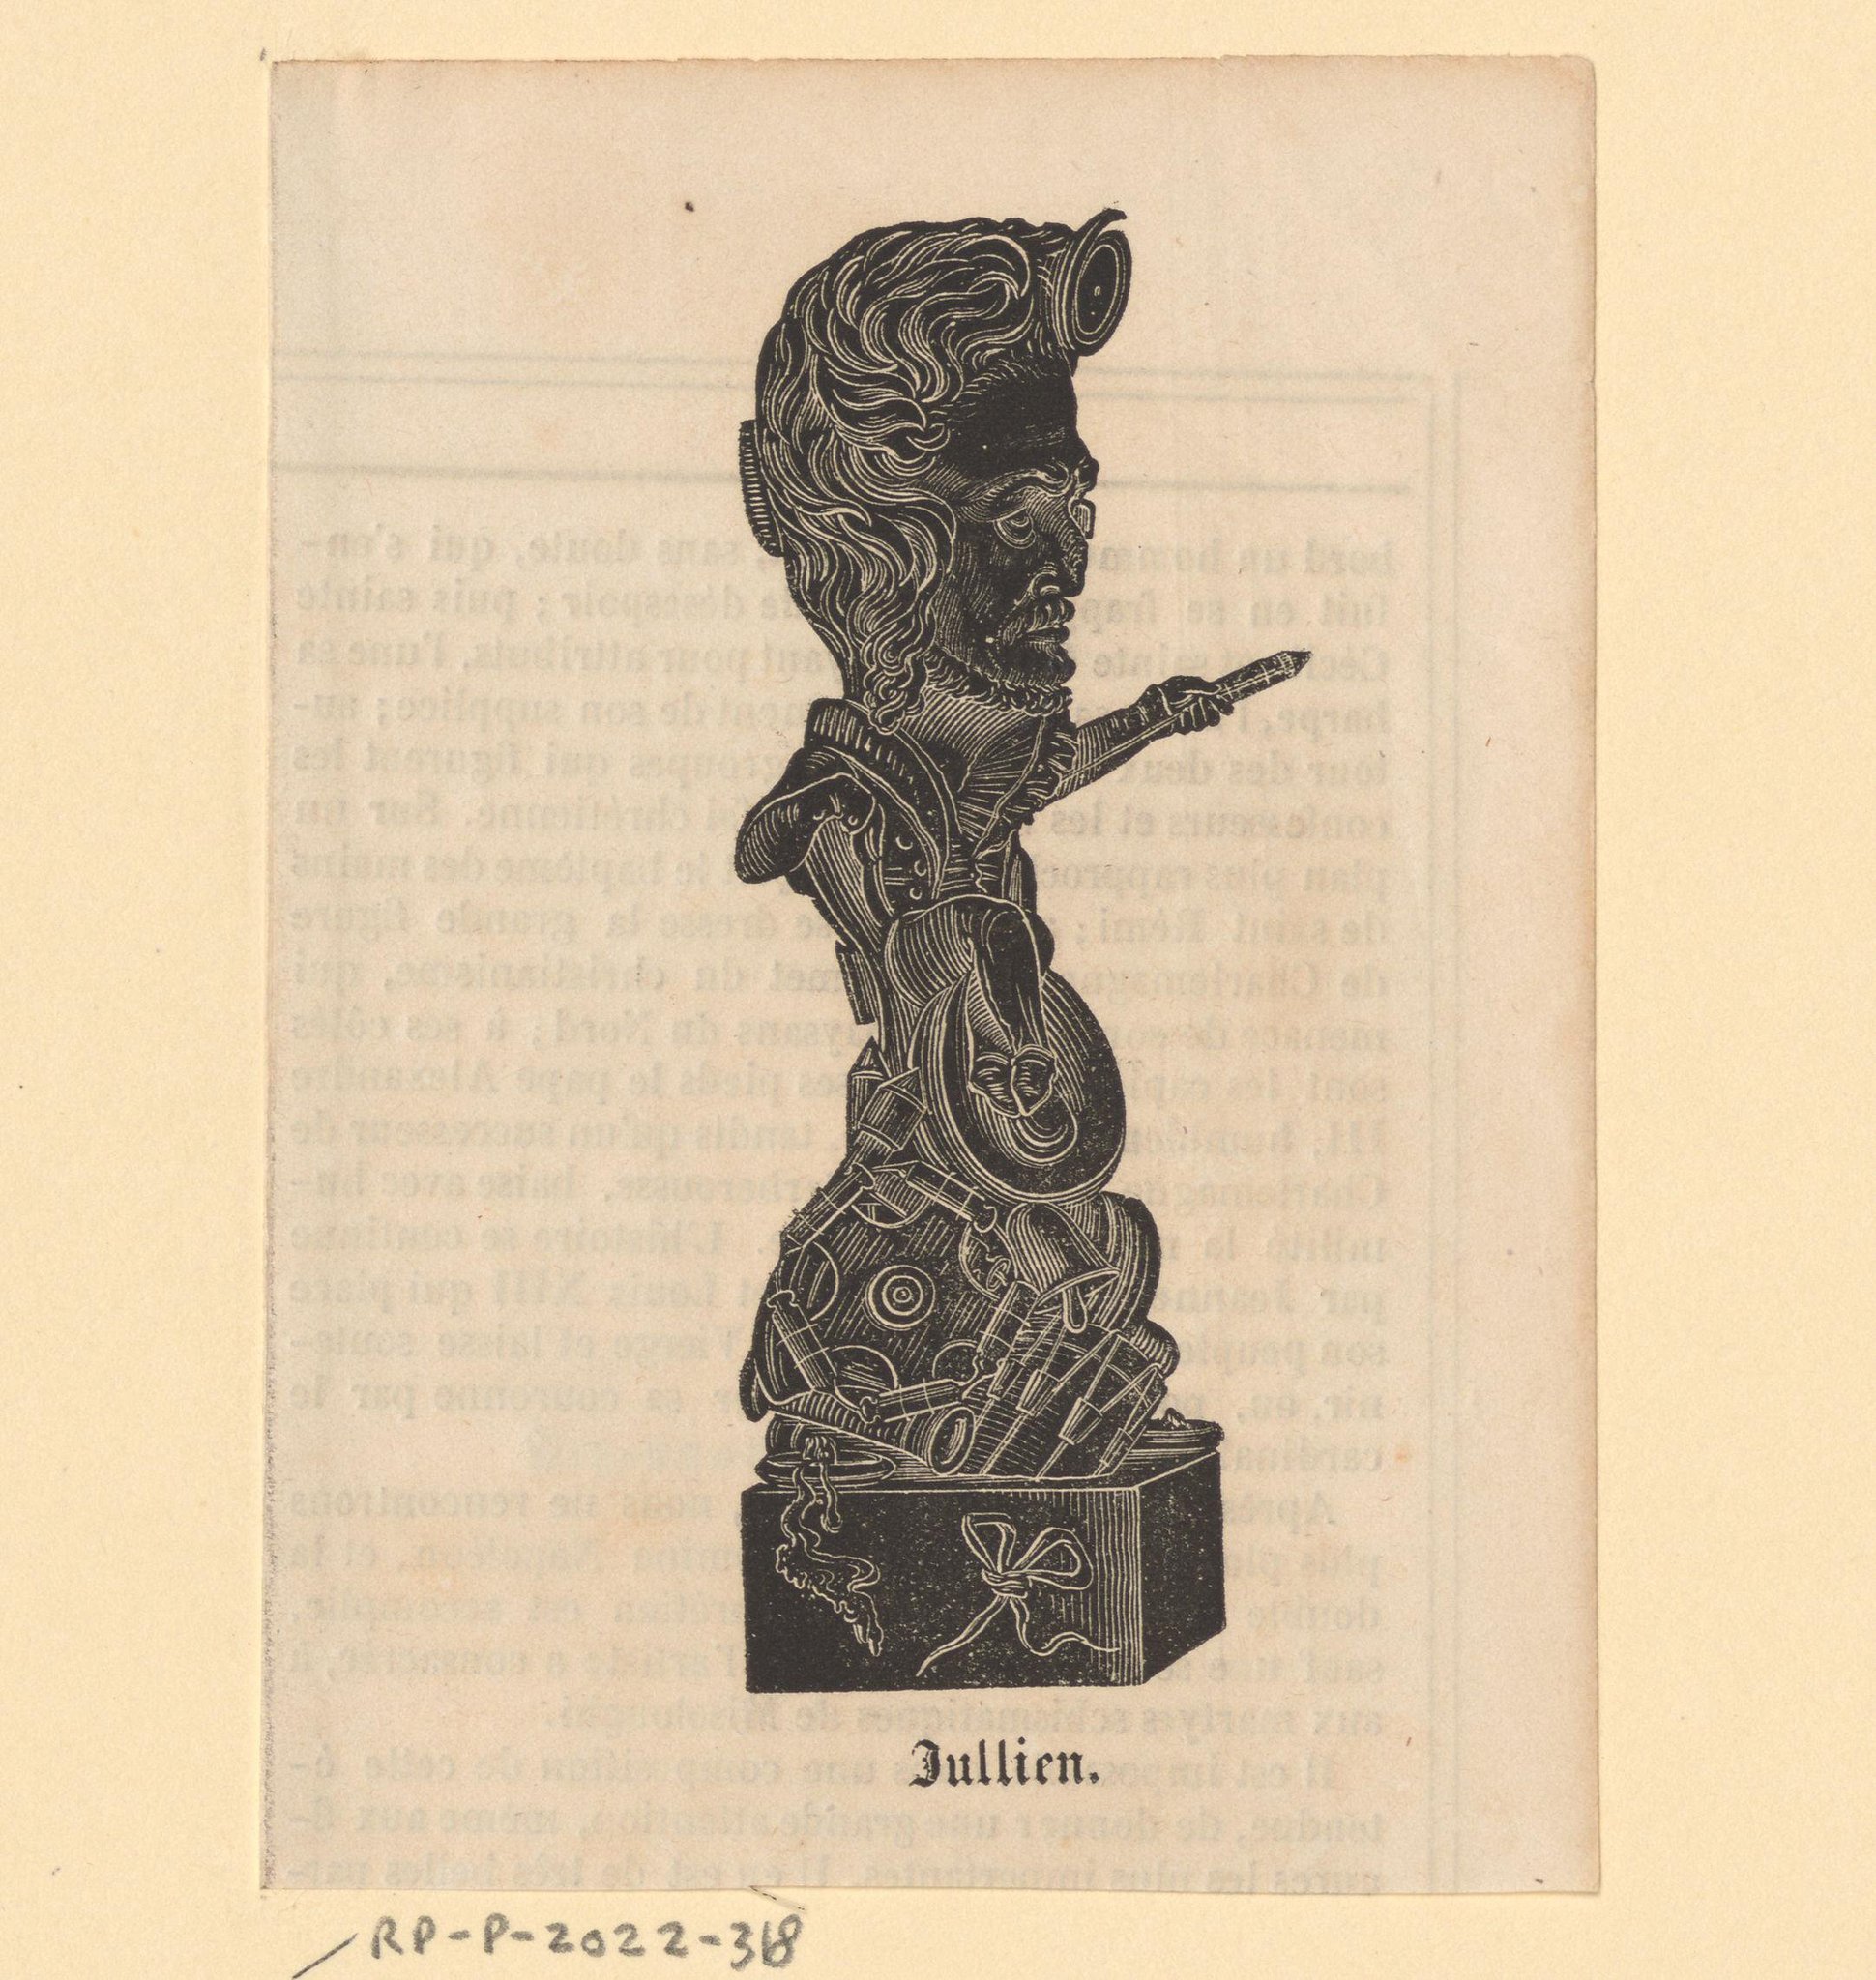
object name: print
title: Portret van Louis-Antoine Jullien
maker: Anonymous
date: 1839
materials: paper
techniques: letterpress printing, engraving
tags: historical persons, composer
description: Prent zonder tekst op verso gebruikt in: Musée Dantan. Galerie des charges et croquis des célébrités de l'époque (...). Parijs: Henri Delloye, 1839.